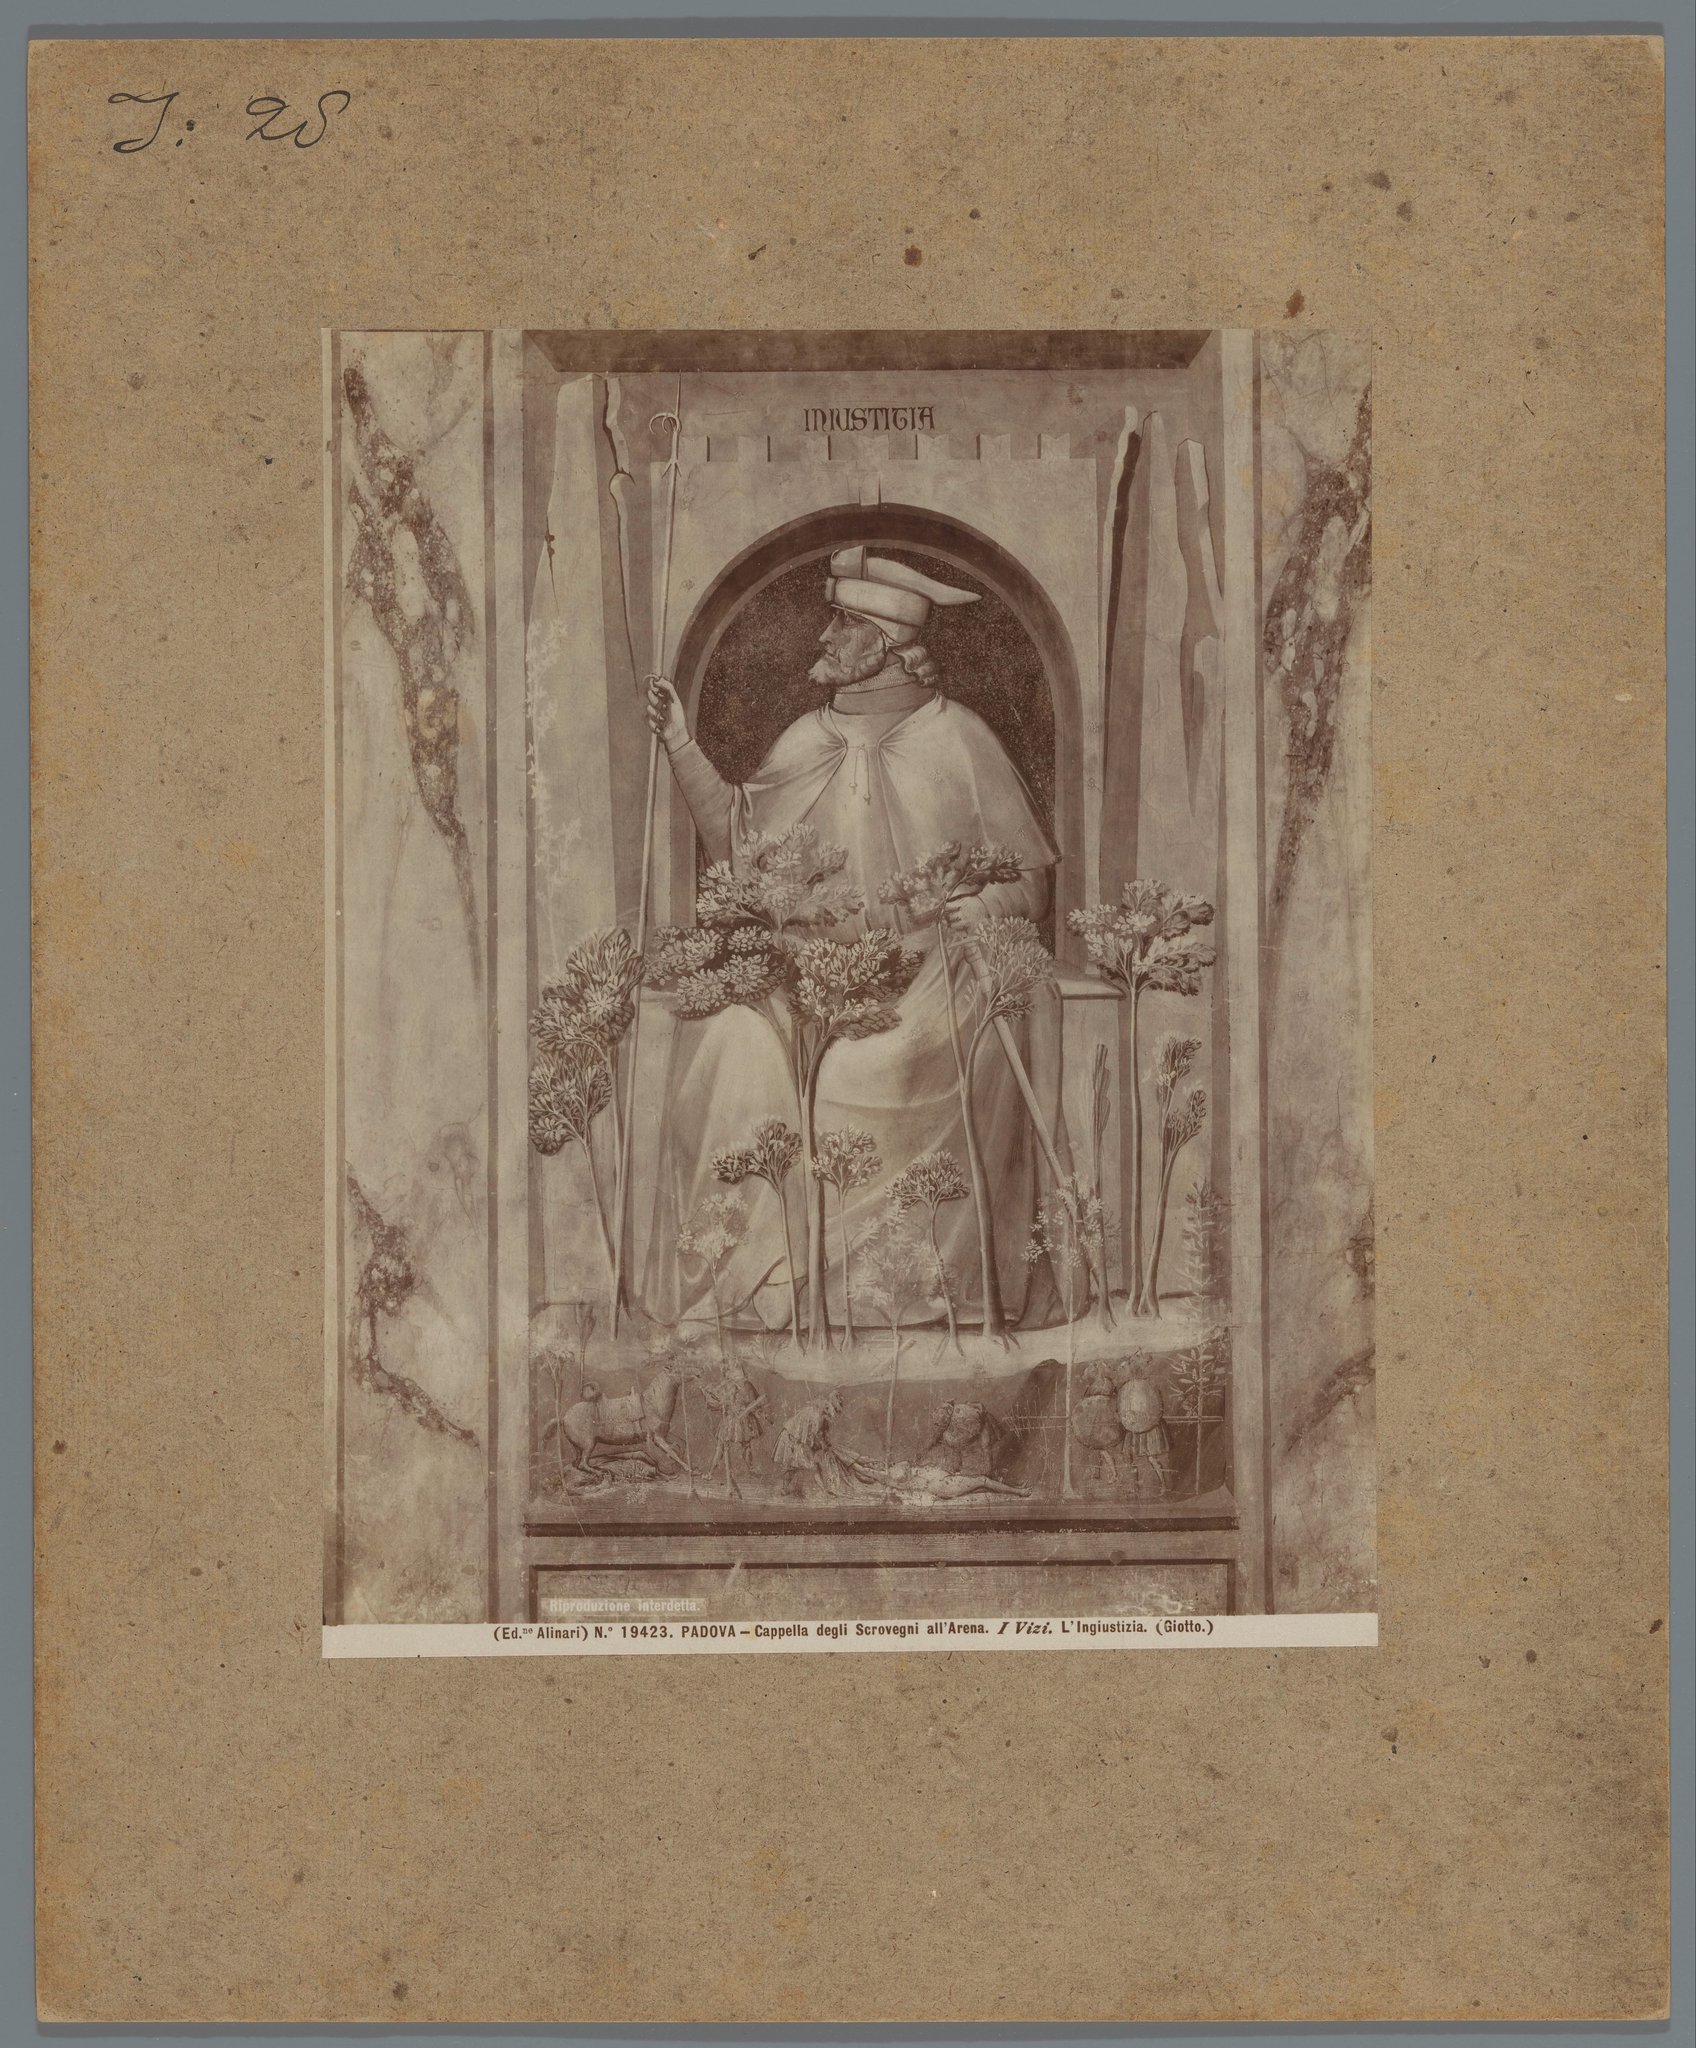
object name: reproduction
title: Fotoreproductie van een fresco door Giotto, voorstellende het Onrecht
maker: giotto de bondone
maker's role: painter, sculptor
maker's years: 1266-1337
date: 1875-1900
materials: cardboard, photographic support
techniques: albumen print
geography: scrovegnikapel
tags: injustice; 'ingiustitia' (ripa)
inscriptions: number: ‘No. 19423.’, collector's mark: Lugt 3937